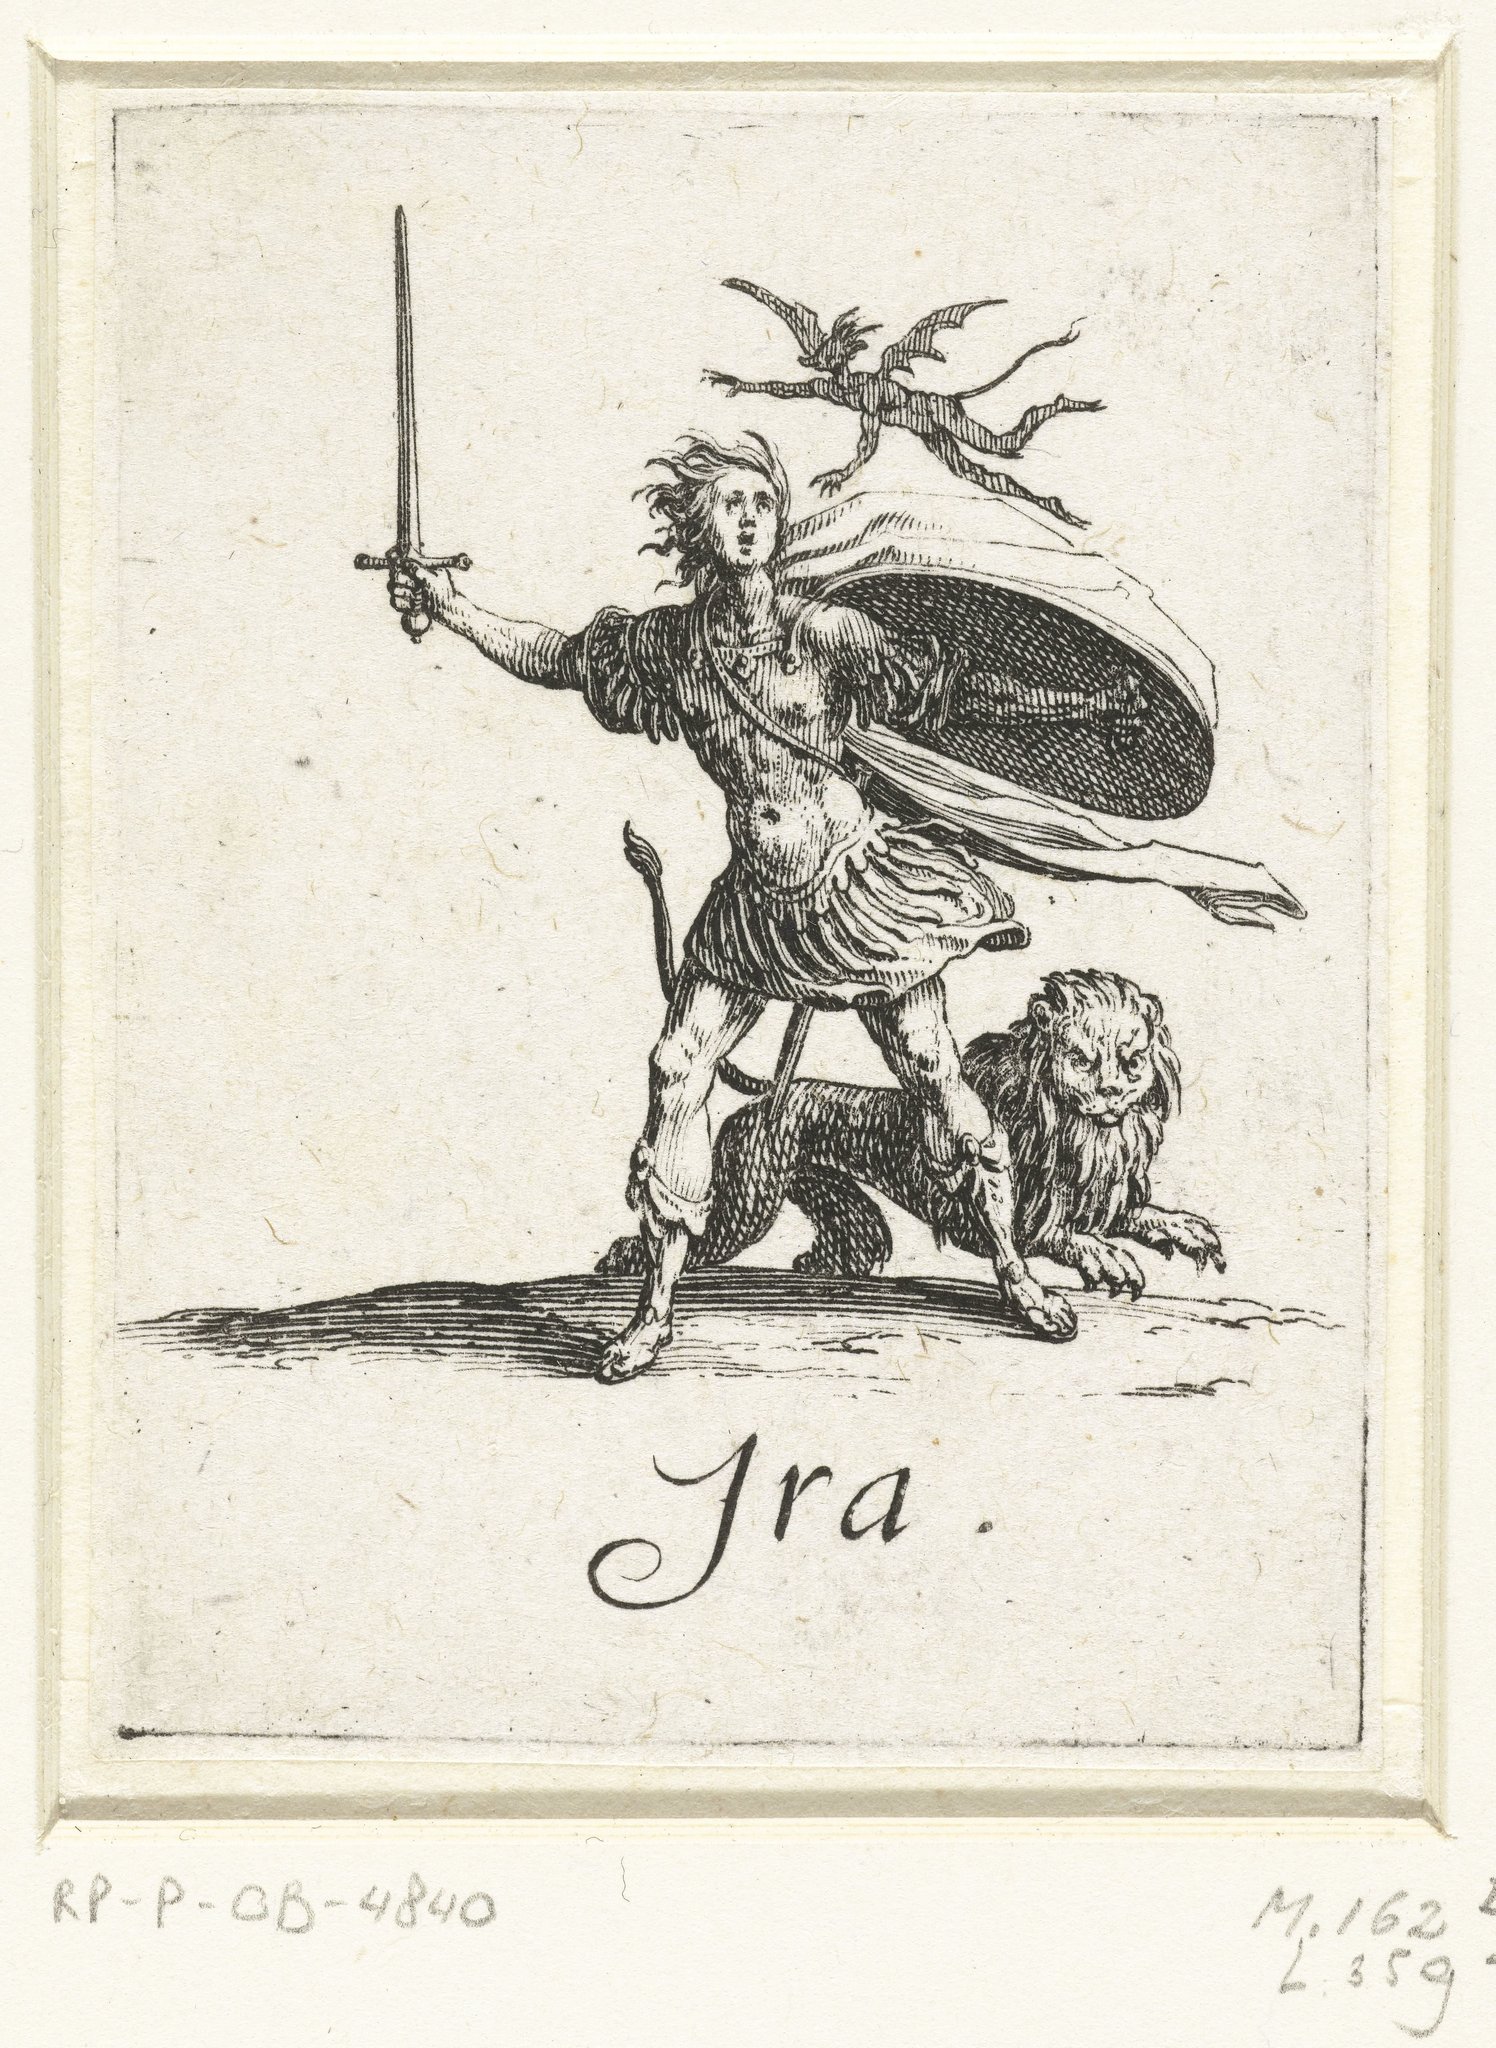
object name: print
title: Woede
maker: jacques callot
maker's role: draughtsman, print maker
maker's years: 1592-1635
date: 1618-1625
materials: paper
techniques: etching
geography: florence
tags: anger; 'ira' (ripa) ~ personification of one of the seven deadly sins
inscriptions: collector's mark: Lugt 240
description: Een soldaat staat klaar om aan te vallen met zijn zwaard. Achter hem staat een leeuw, boven hem vliegt een duiveltje. Onder de voorstelling de Latijnse term voor de zonde die de man verbeeldt. Deze prent is onderdeel van een serie van zeven prenten waarop de hoofdzonden als allegorische figuren zijn weergegeven.